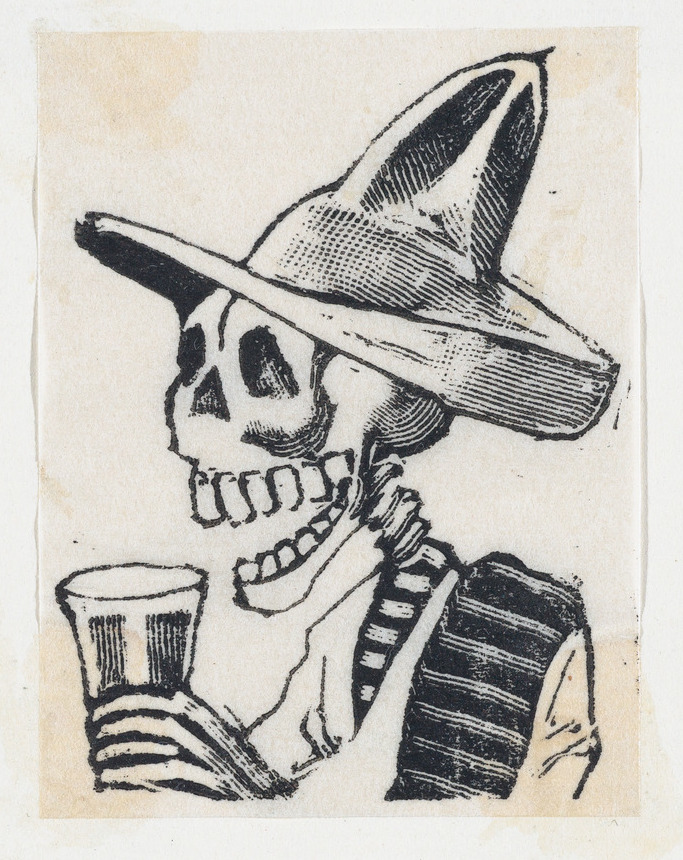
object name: print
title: A skeleton wearing a hat having a drink (vignette for the feast of the dead)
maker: josé guadalupe posada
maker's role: artist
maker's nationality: mexican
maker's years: 1852-1913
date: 1892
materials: metal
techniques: engraving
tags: skeletons,drinking